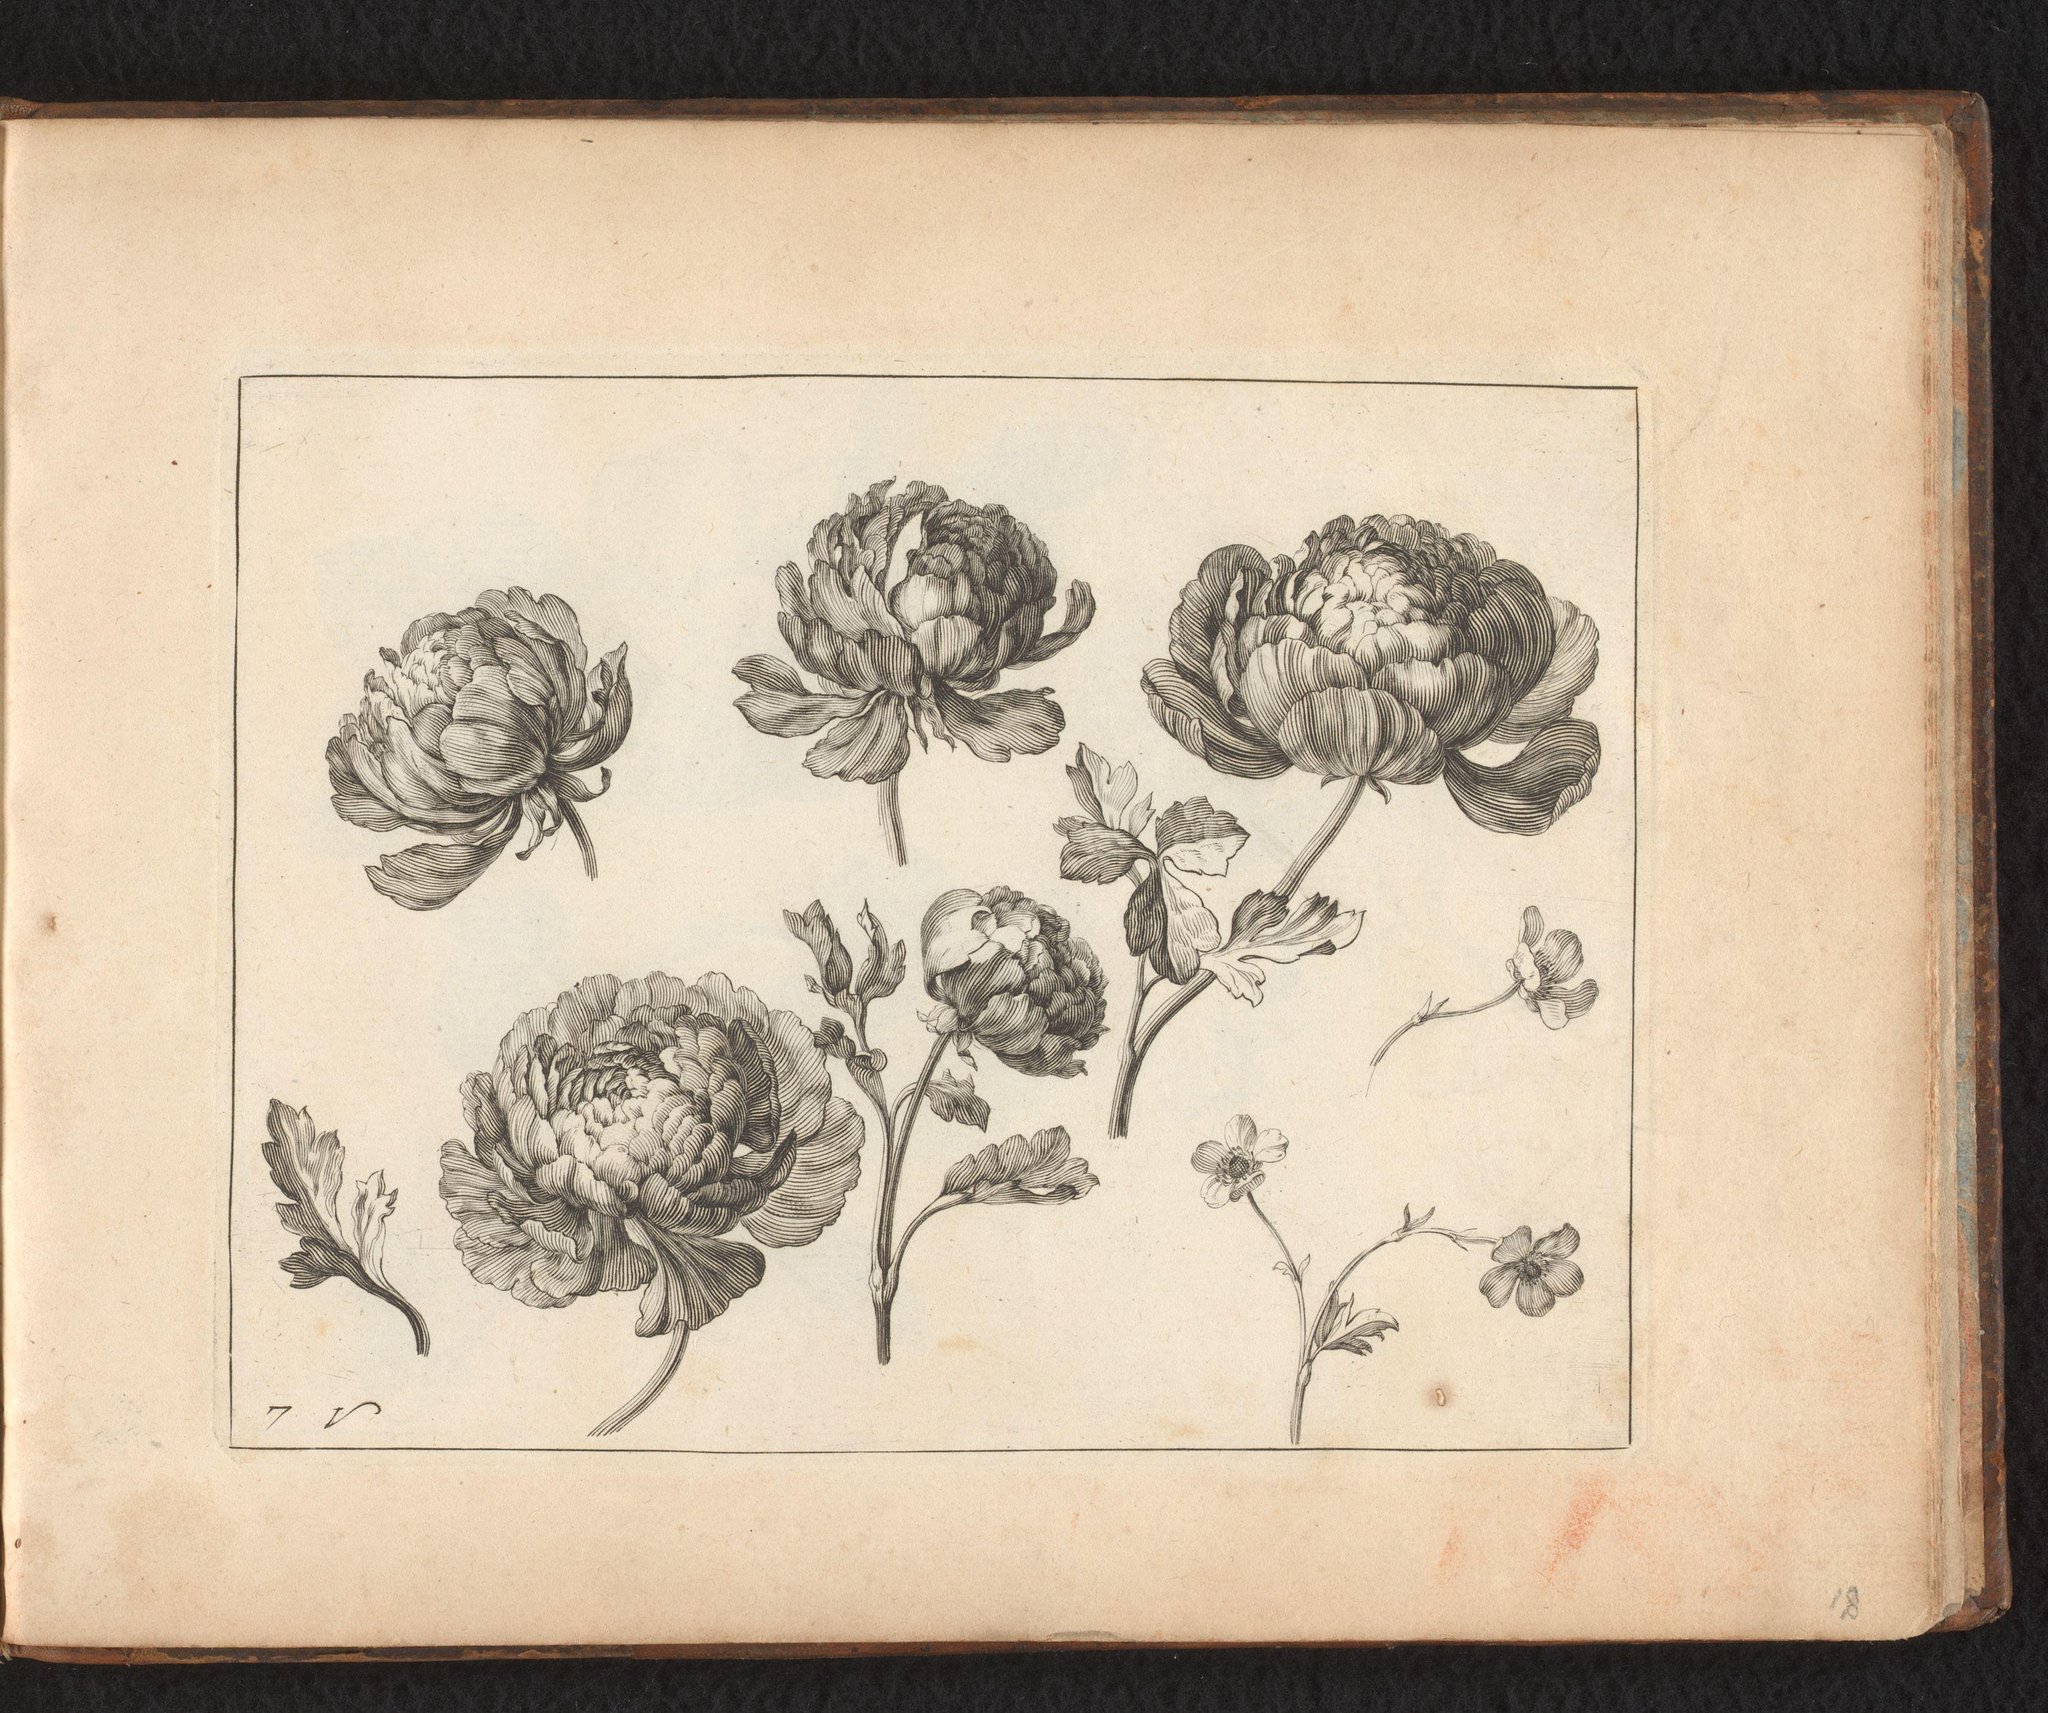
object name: album leaf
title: Bloeiwijze van de pioenroos en details van de plant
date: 1650-1676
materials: paper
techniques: engraving, etching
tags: flowers: peony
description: Deze prent maakt deel uit van een album.